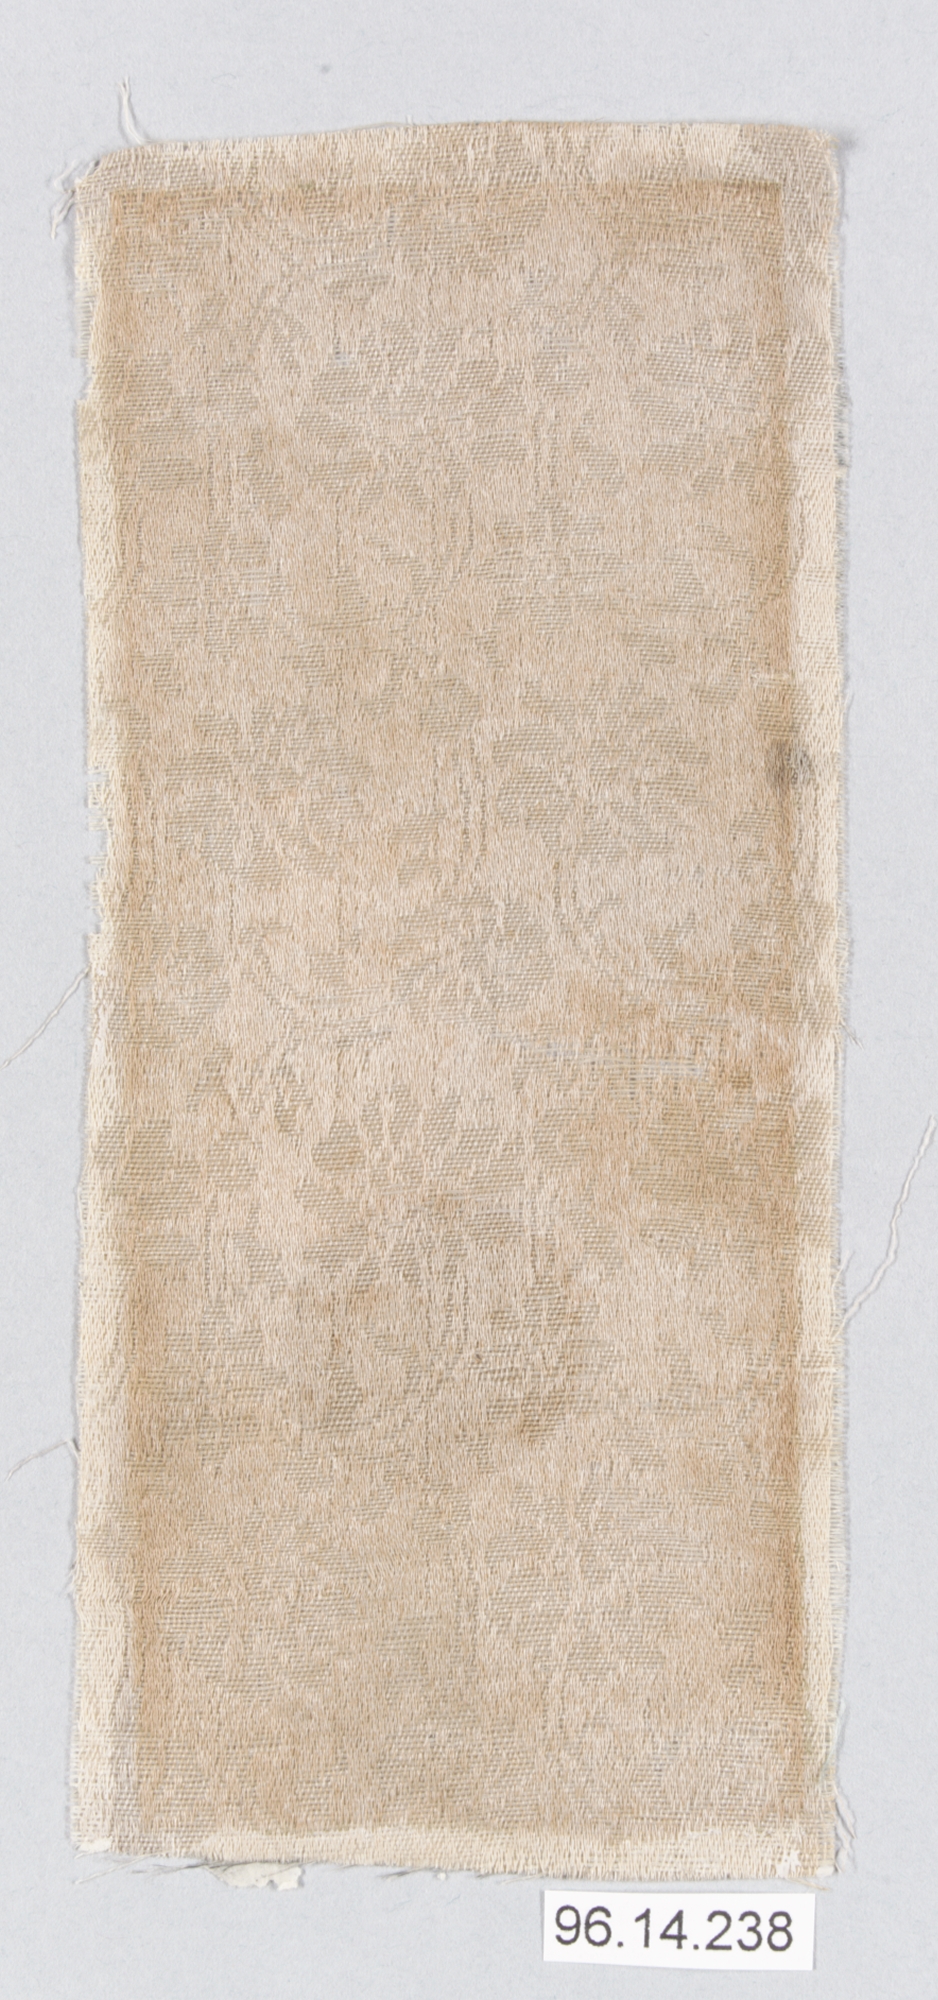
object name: piece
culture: japanese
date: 1701-1900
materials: silk